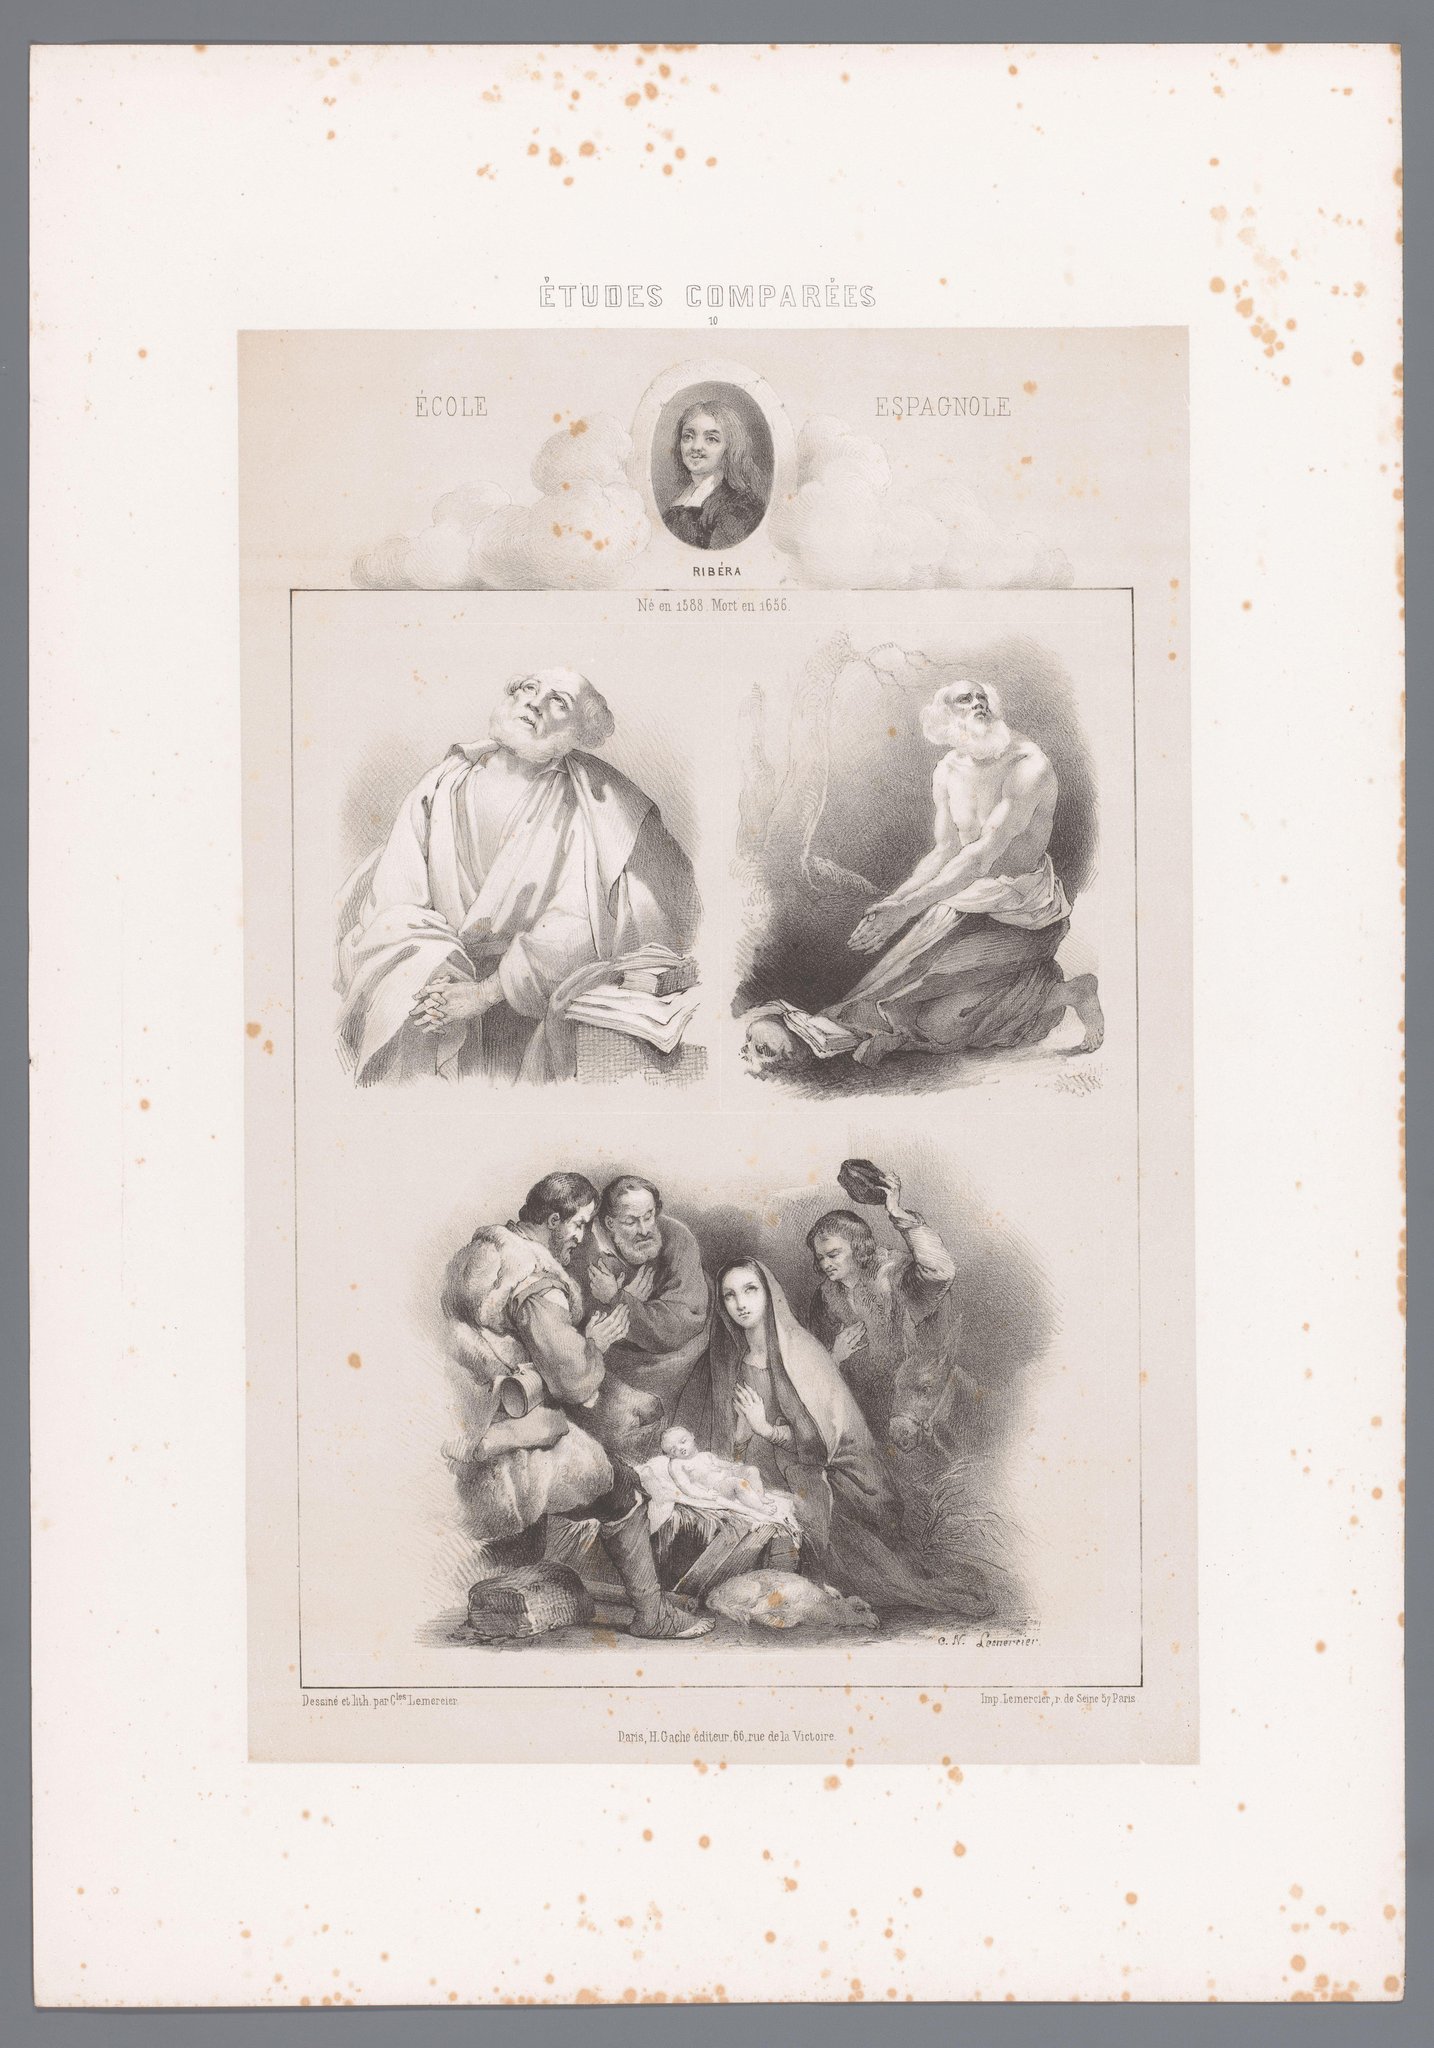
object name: print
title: Studies ter vergelijking van meesters uit verschillende schilderscholen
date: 1850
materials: paper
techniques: tone lithography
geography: paris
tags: naples, painter, draughtsman, jusepe de ribera, historical persons, painting (including book-illumination, miniature-painting)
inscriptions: collector's mark: Lugt 2228a